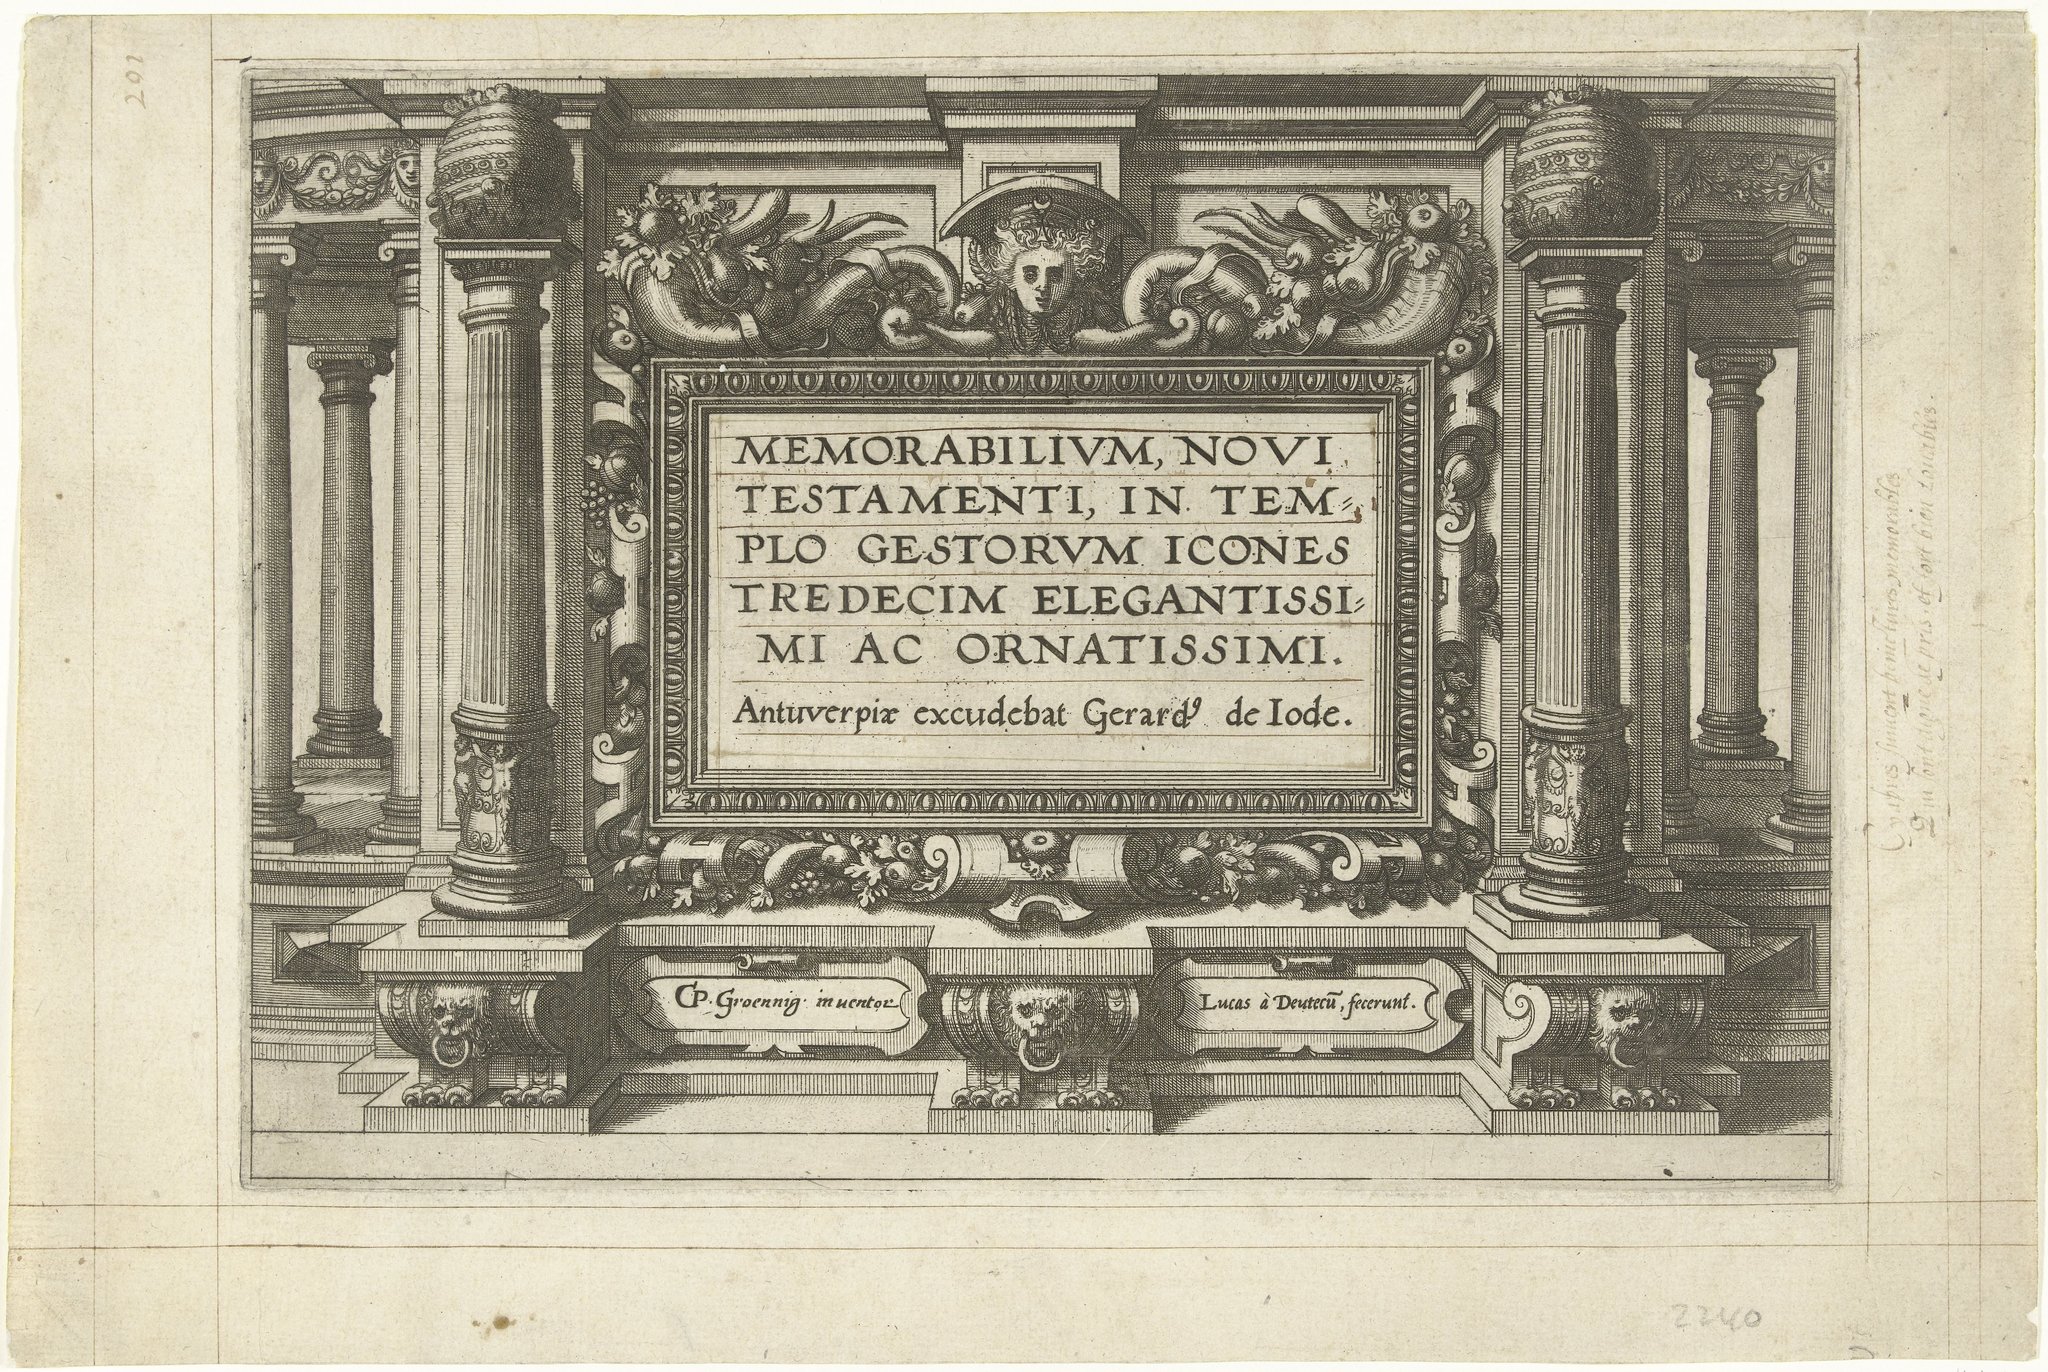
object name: titelprent, frontispice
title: Memorabilivm Novi Testamenti in templo gestorvm icones tredecim elegantissimi ac ornatissimi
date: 1572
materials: paper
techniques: engraving, etching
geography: antwerp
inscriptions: inscription: ‘Cyapres suivent penictures memorables [...]’, collector's mark: Lugt 2228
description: Architecturale titelprent voor een serie van 13 prenten met gebeurtenissen uit het Nieuwe Testament die zich afspelen rondom de tempel.